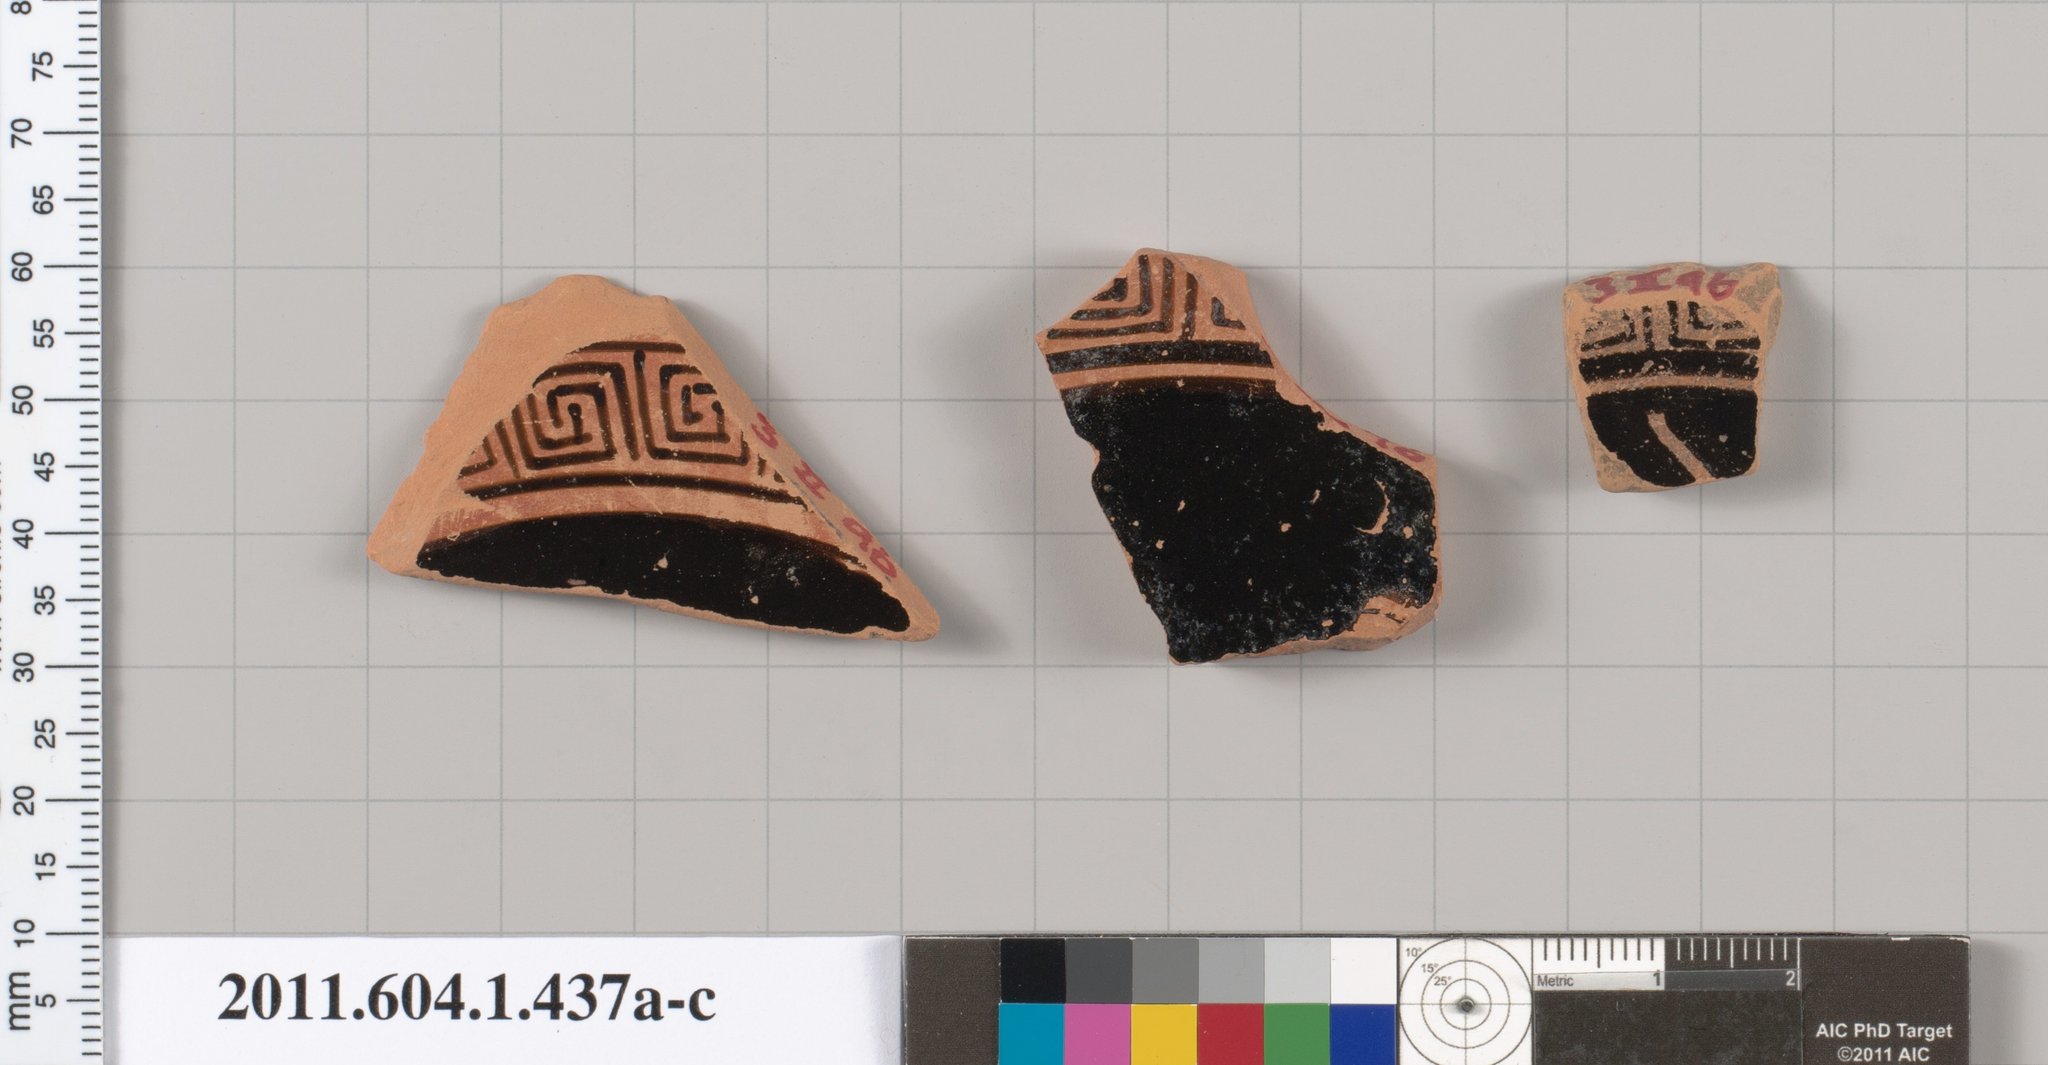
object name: kylix fragment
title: Terracotta fragments of kylikes (drinking cups)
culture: greek, attic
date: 475-451 BCE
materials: terracotta